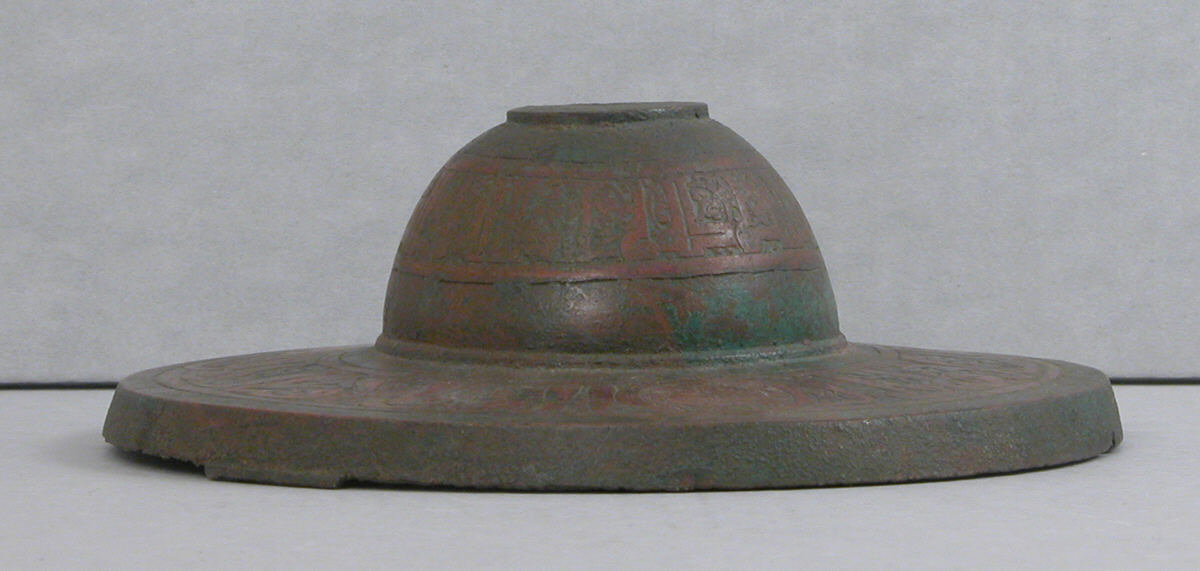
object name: lid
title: Possibly a Lid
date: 1167-1233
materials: bronze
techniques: casting, engraving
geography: iran